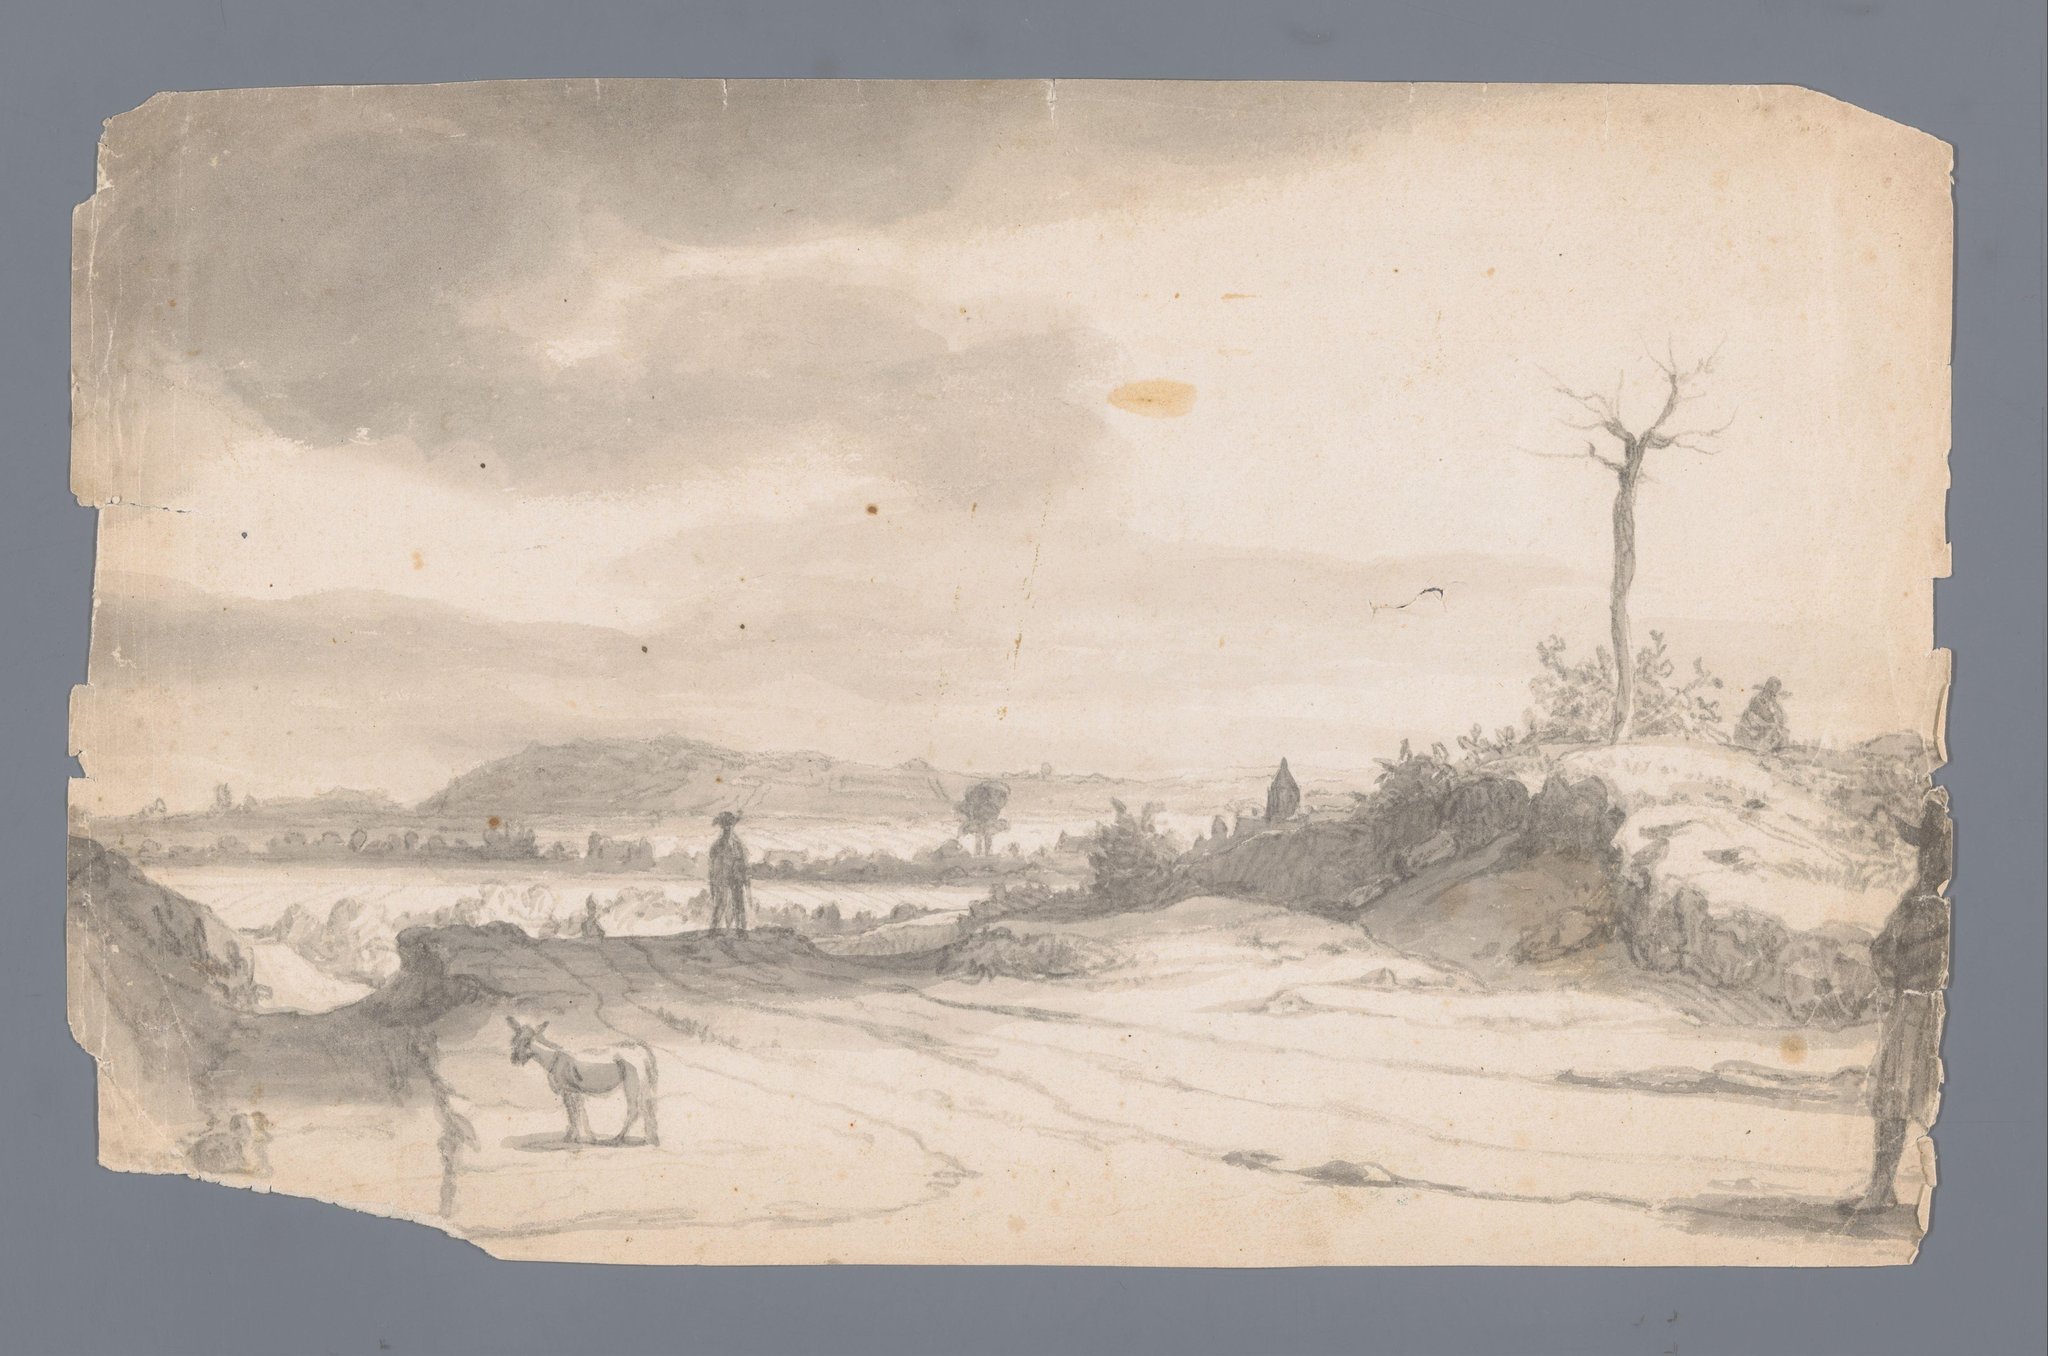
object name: drawing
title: Landschap bij Renkum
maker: jan brandes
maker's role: draughtsman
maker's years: 1743-1808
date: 1775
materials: ink, paper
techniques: brush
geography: renkum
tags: low hill country (+ landscape with figures, staffage)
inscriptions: inscription: ‘Rinckum buyten Wageningen’